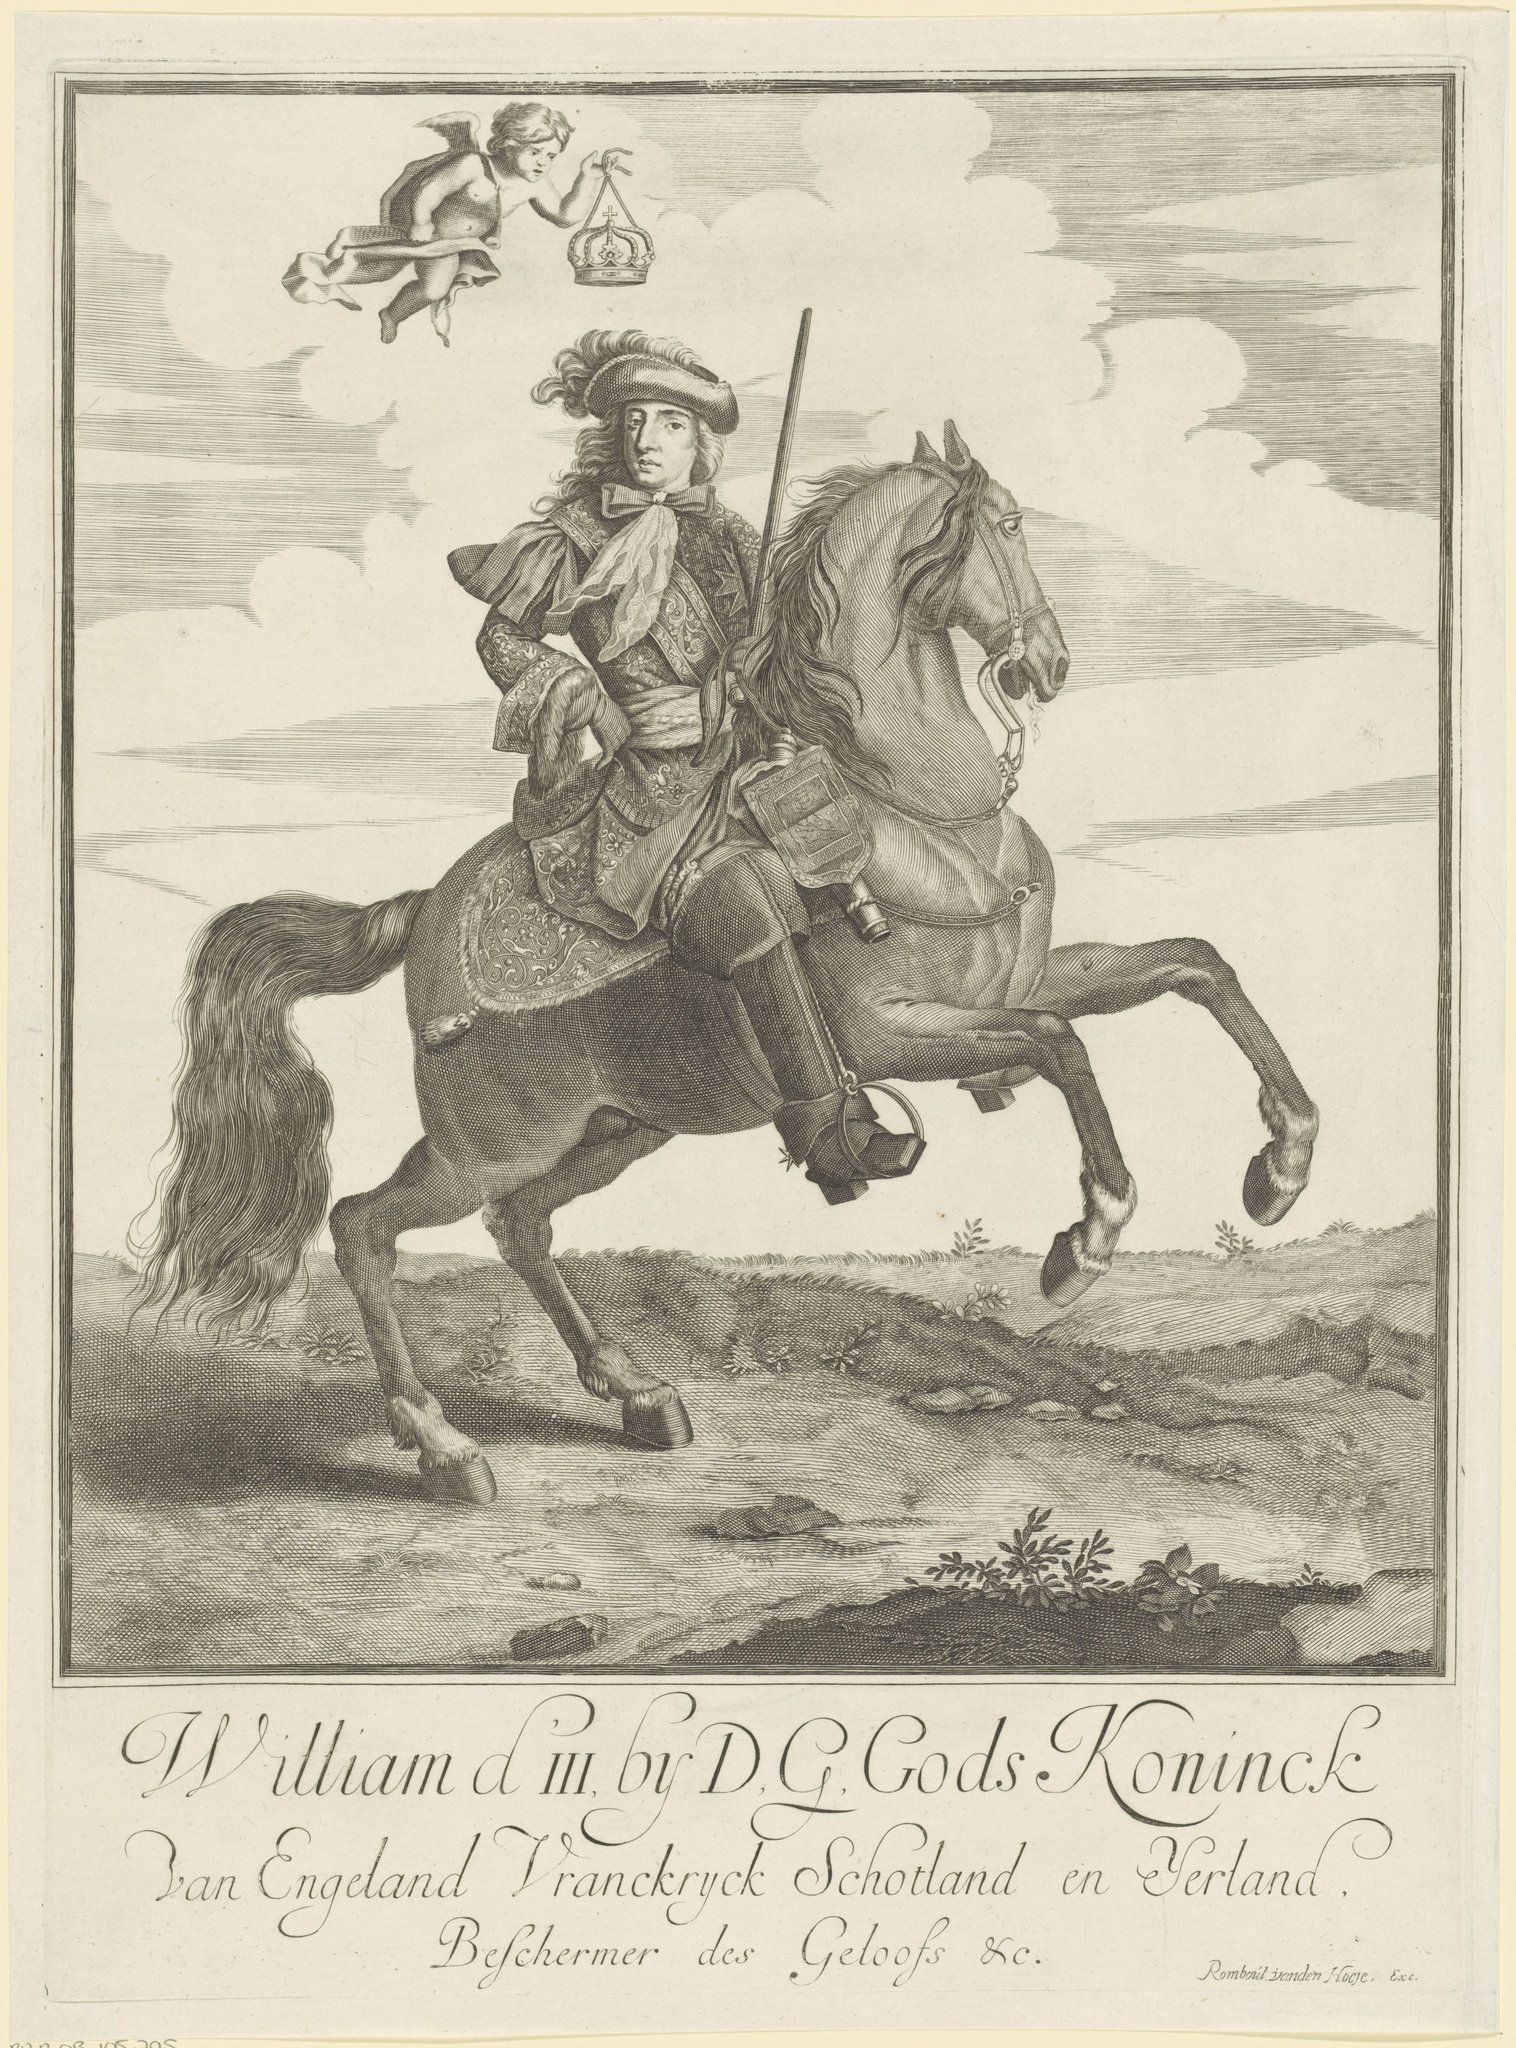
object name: print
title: Ruiterportret van Willem III, prins van Oranje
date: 1688-1691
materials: paper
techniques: engraving, etching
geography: amsterdam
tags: william iii (prince of orange and king of england, scotland, and ireland)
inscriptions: collector's mark: Lugt 963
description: De hier vermelde titel verwijst naar de hoogst verkregen titel van de geportretteerde, niet per se naar de titel die de geportretteerde op deze voorstelling draagt.